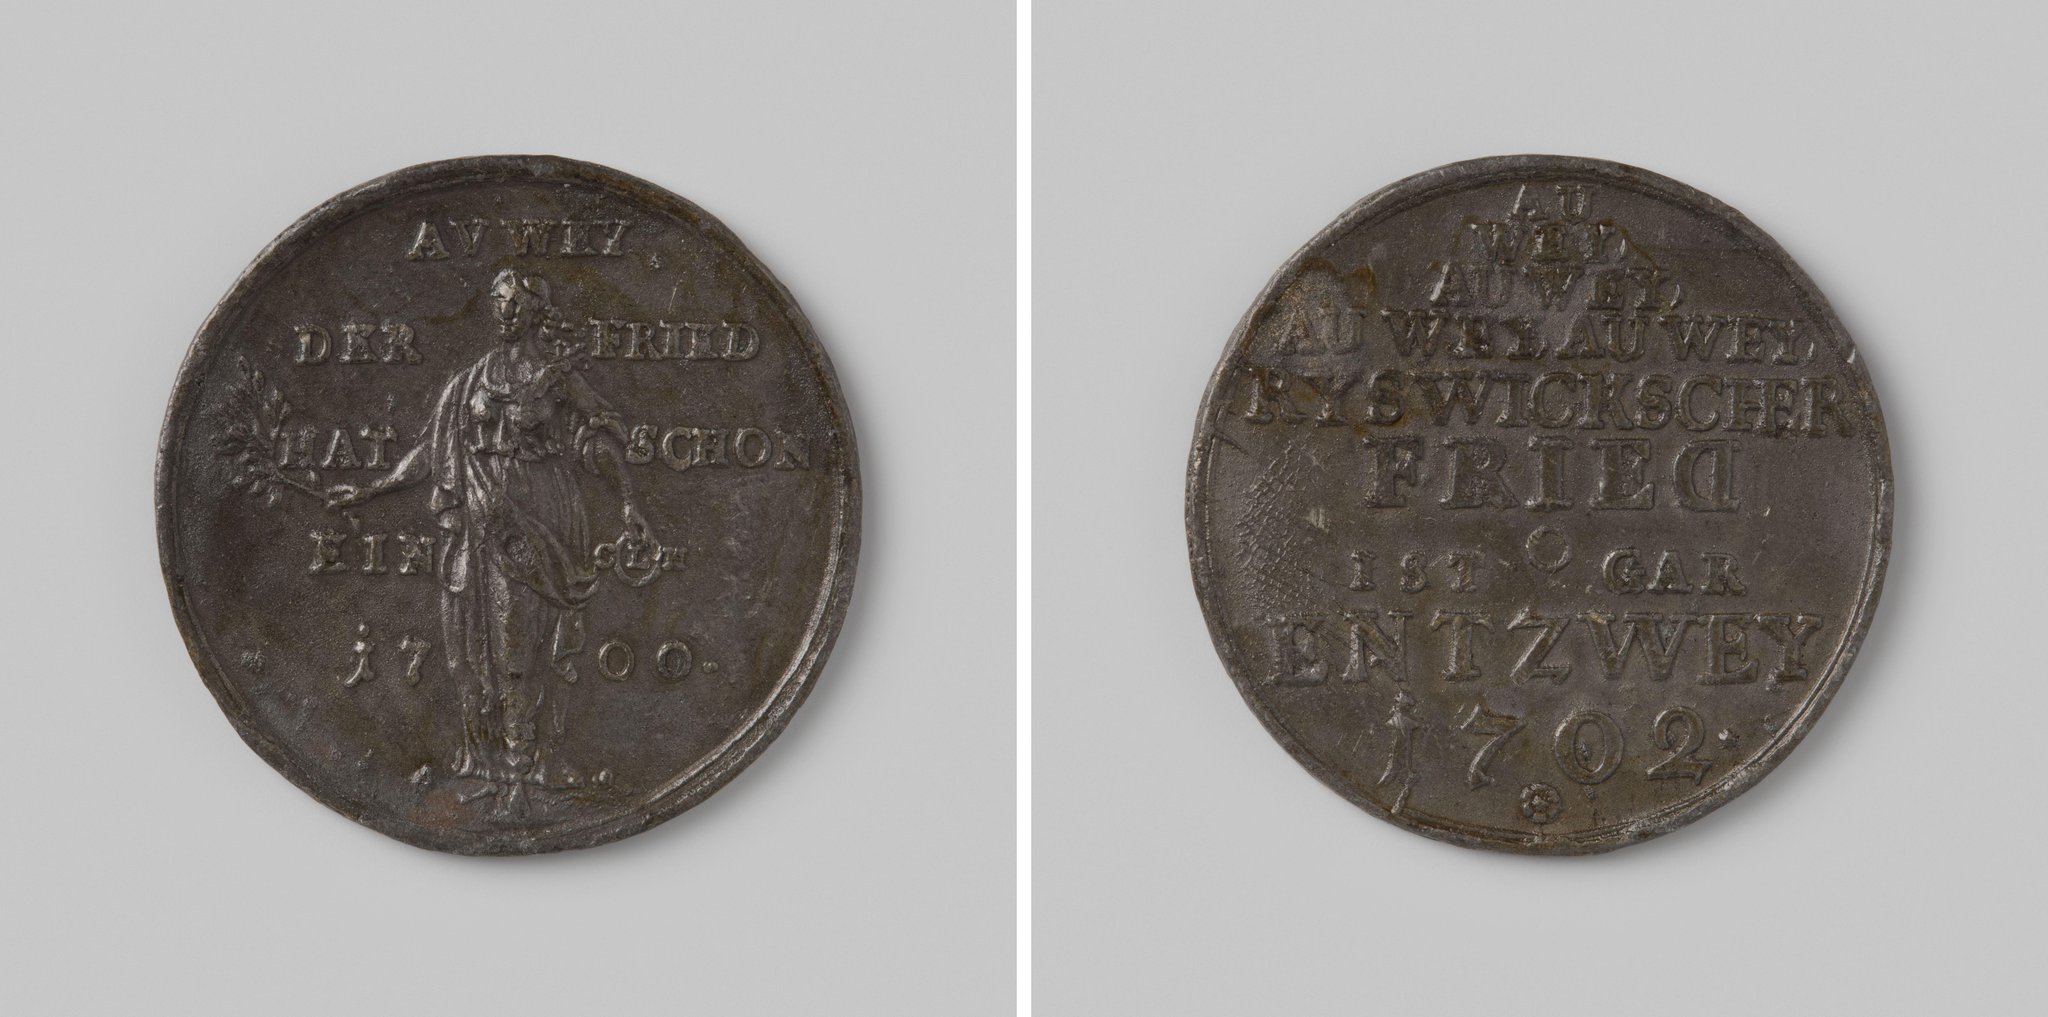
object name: history medal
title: Verbreking van de Vrede van Rijswijk 1702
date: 1702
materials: tin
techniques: casting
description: Tinnen penning, op de voorzijde Pax met olijftak en slangerond staande voor vijf regels tekst, op de keerzijde negen regels tekst.